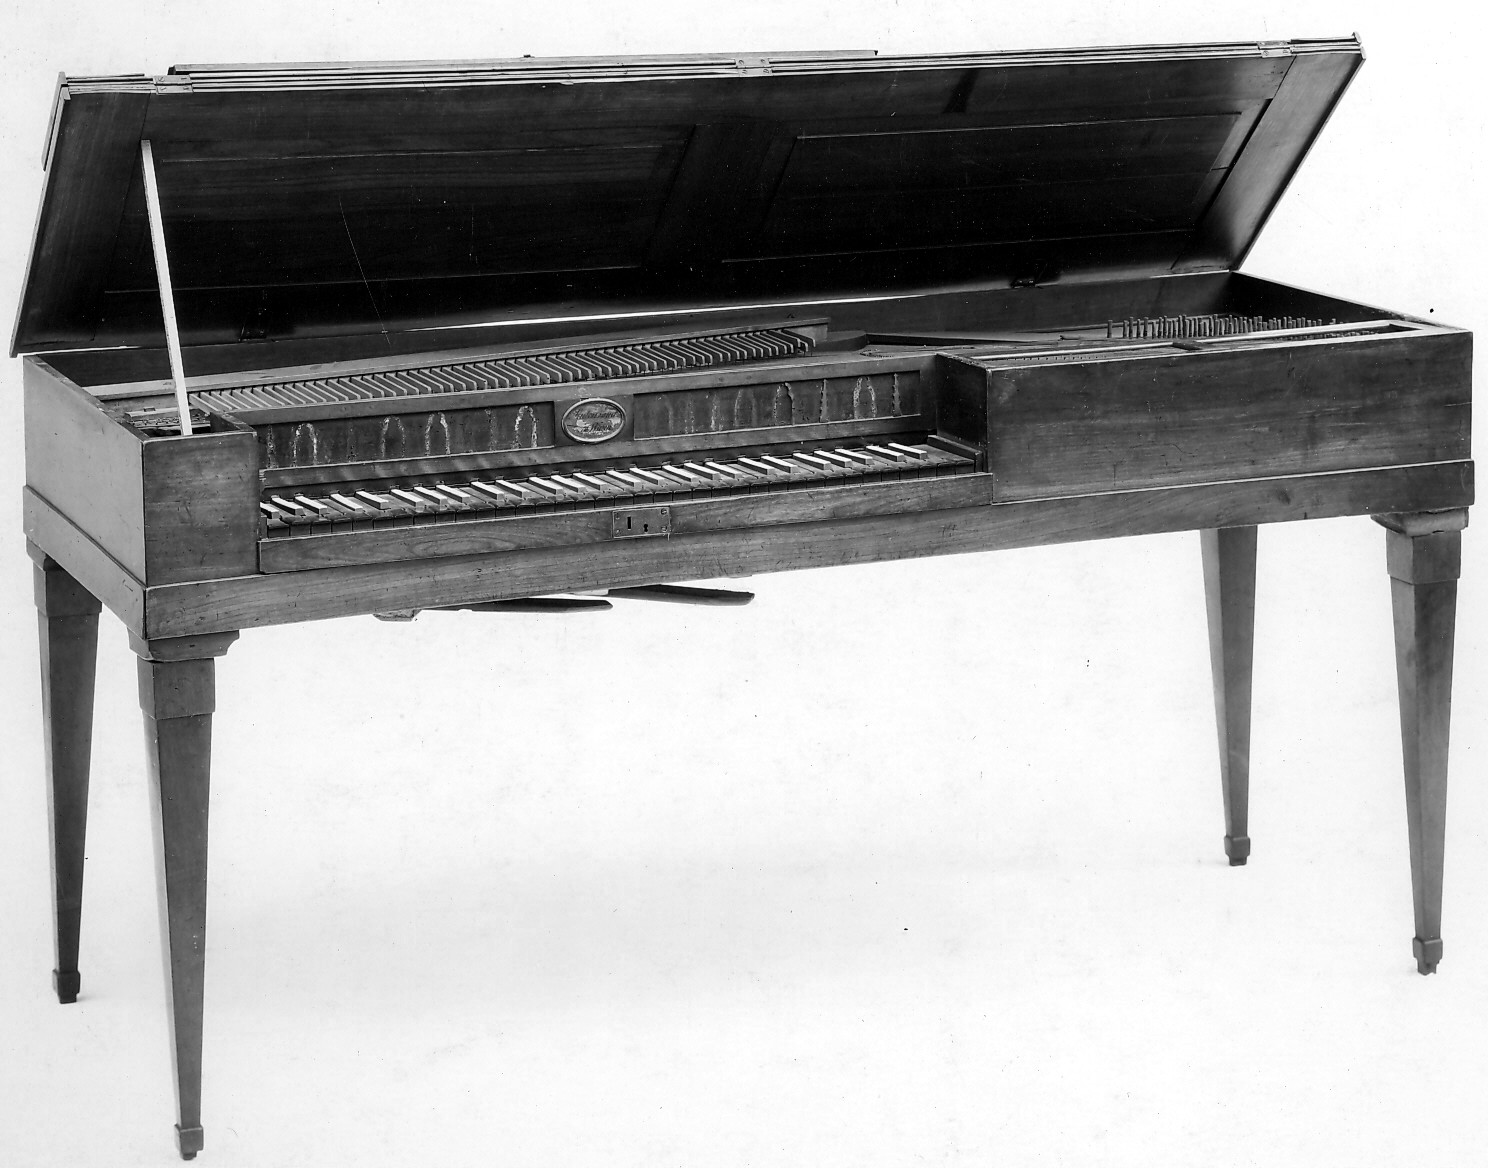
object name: square piano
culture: austrian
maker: anton vatter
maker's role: maker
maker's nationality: austrian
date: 1800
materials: bone, wood, iron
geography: austria